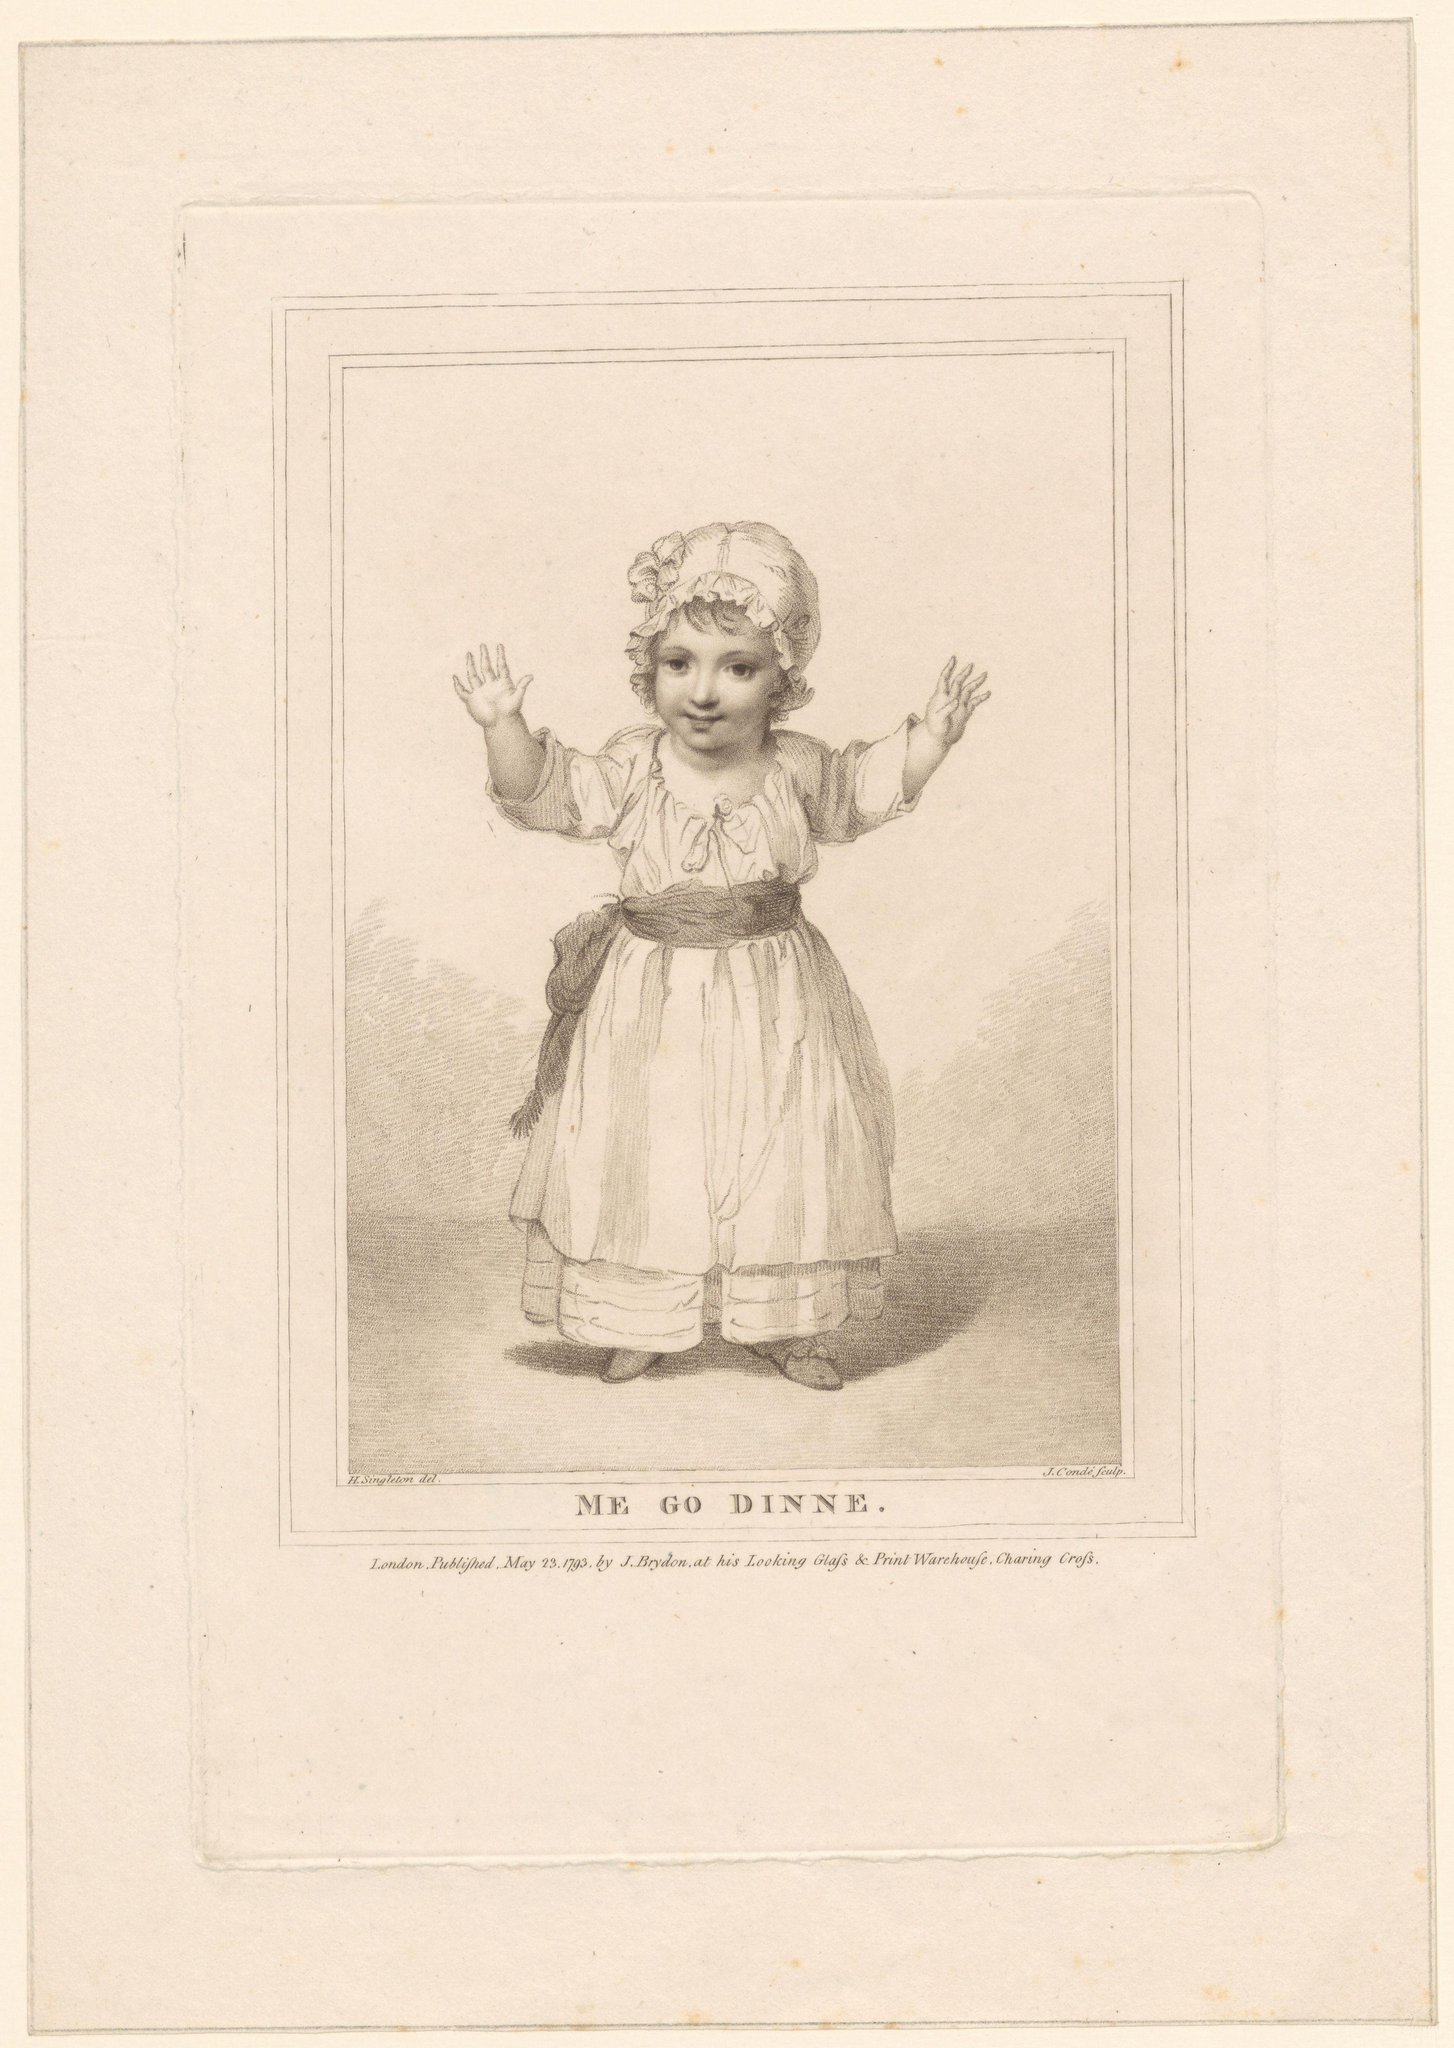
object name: print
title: Jong kind met haar handen in de lucht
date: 1793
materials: paper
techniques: stippling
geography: london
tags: child, child (at home) - aa - girl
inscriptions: collector's mark: Lugt 2233